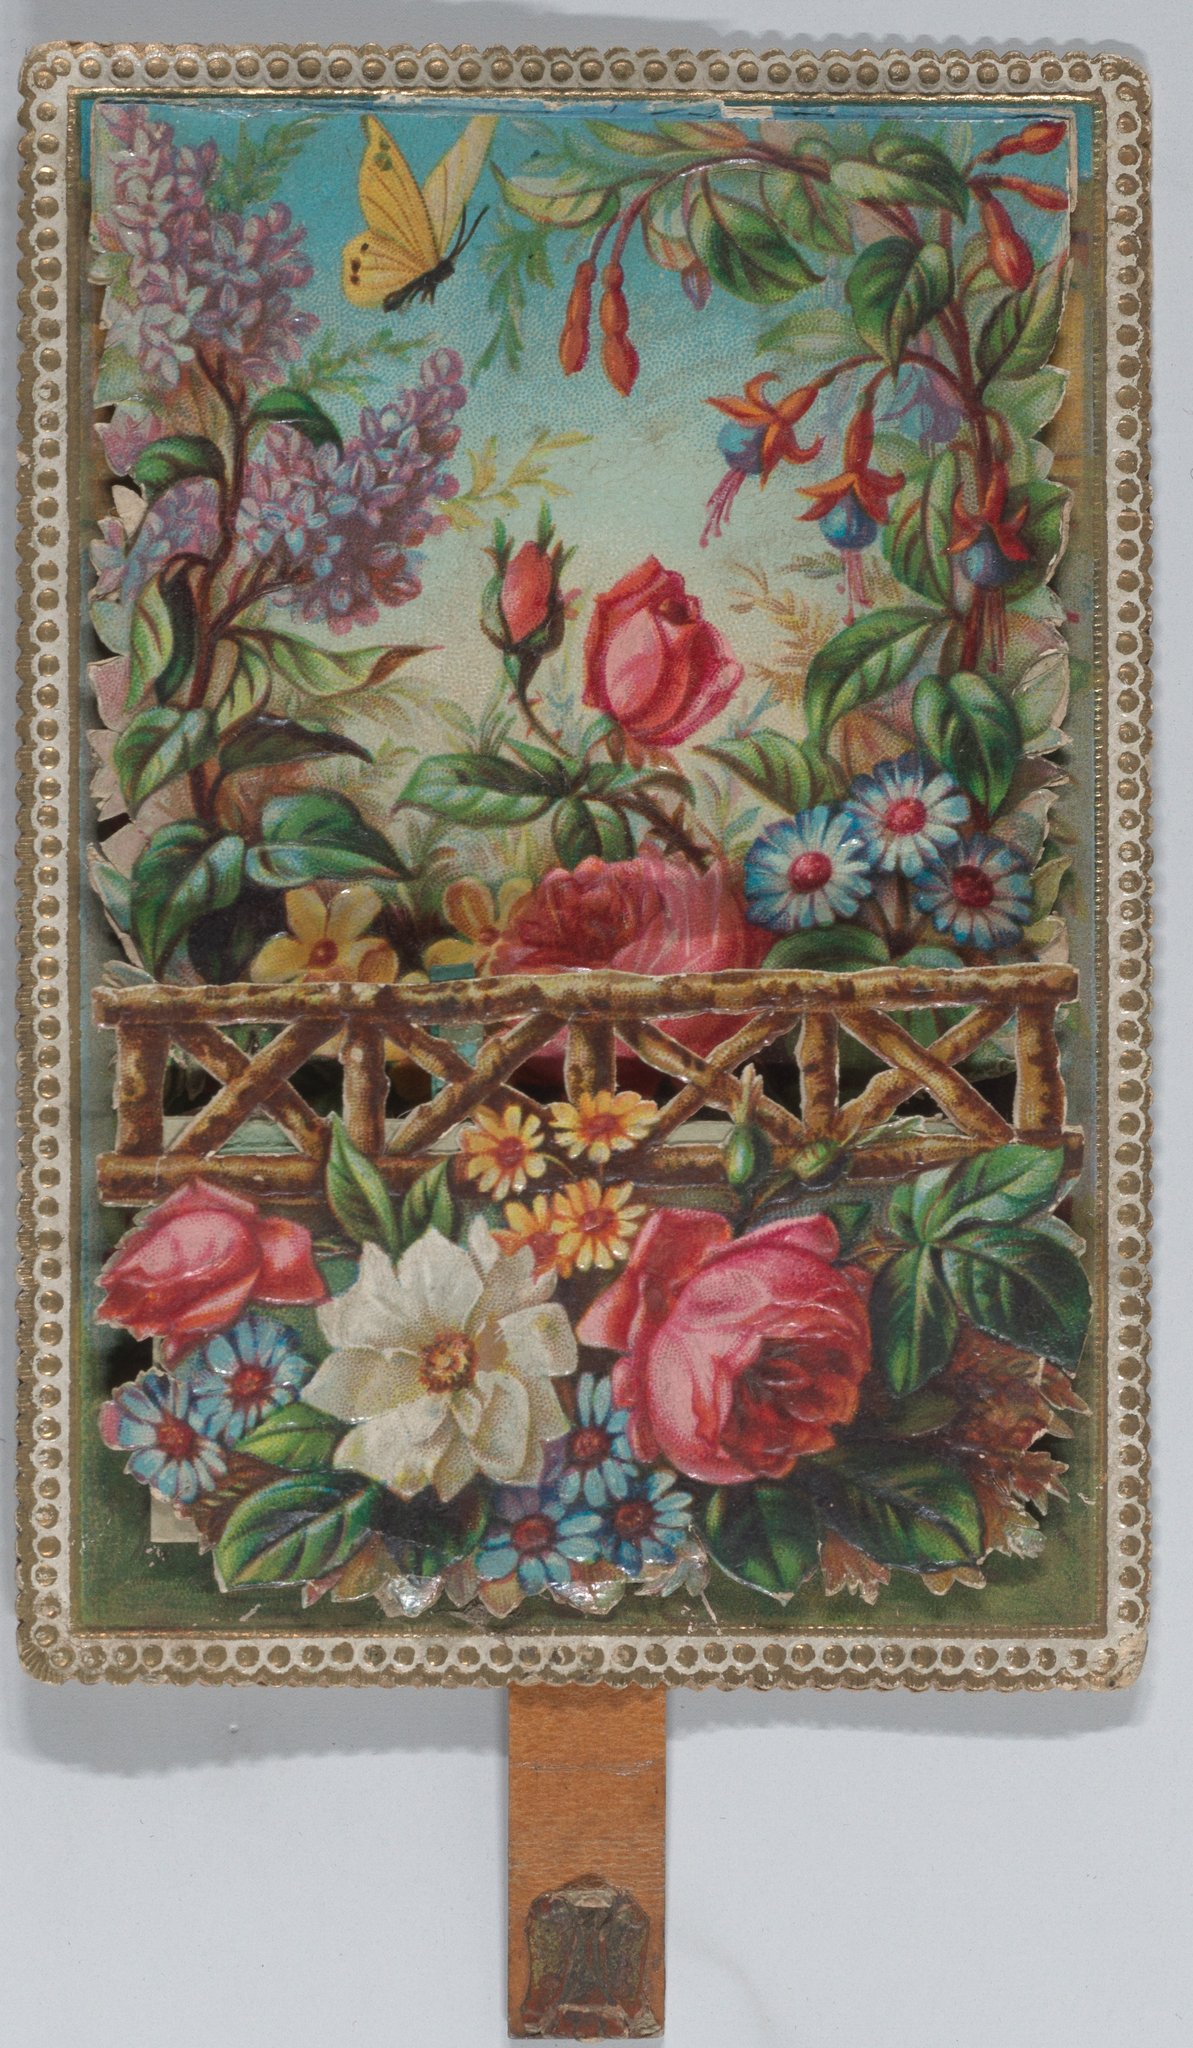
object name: valentine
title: Valentine - Mechanical floral scene - a man on a horse offers a woman a rose - symbol of love.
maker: anonymous, british, 19th century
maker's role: artist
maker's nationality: british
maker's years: 1800-1900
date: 1875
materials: paper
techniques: chromolithography, cutting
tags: men,women,dogs,horses,flowers